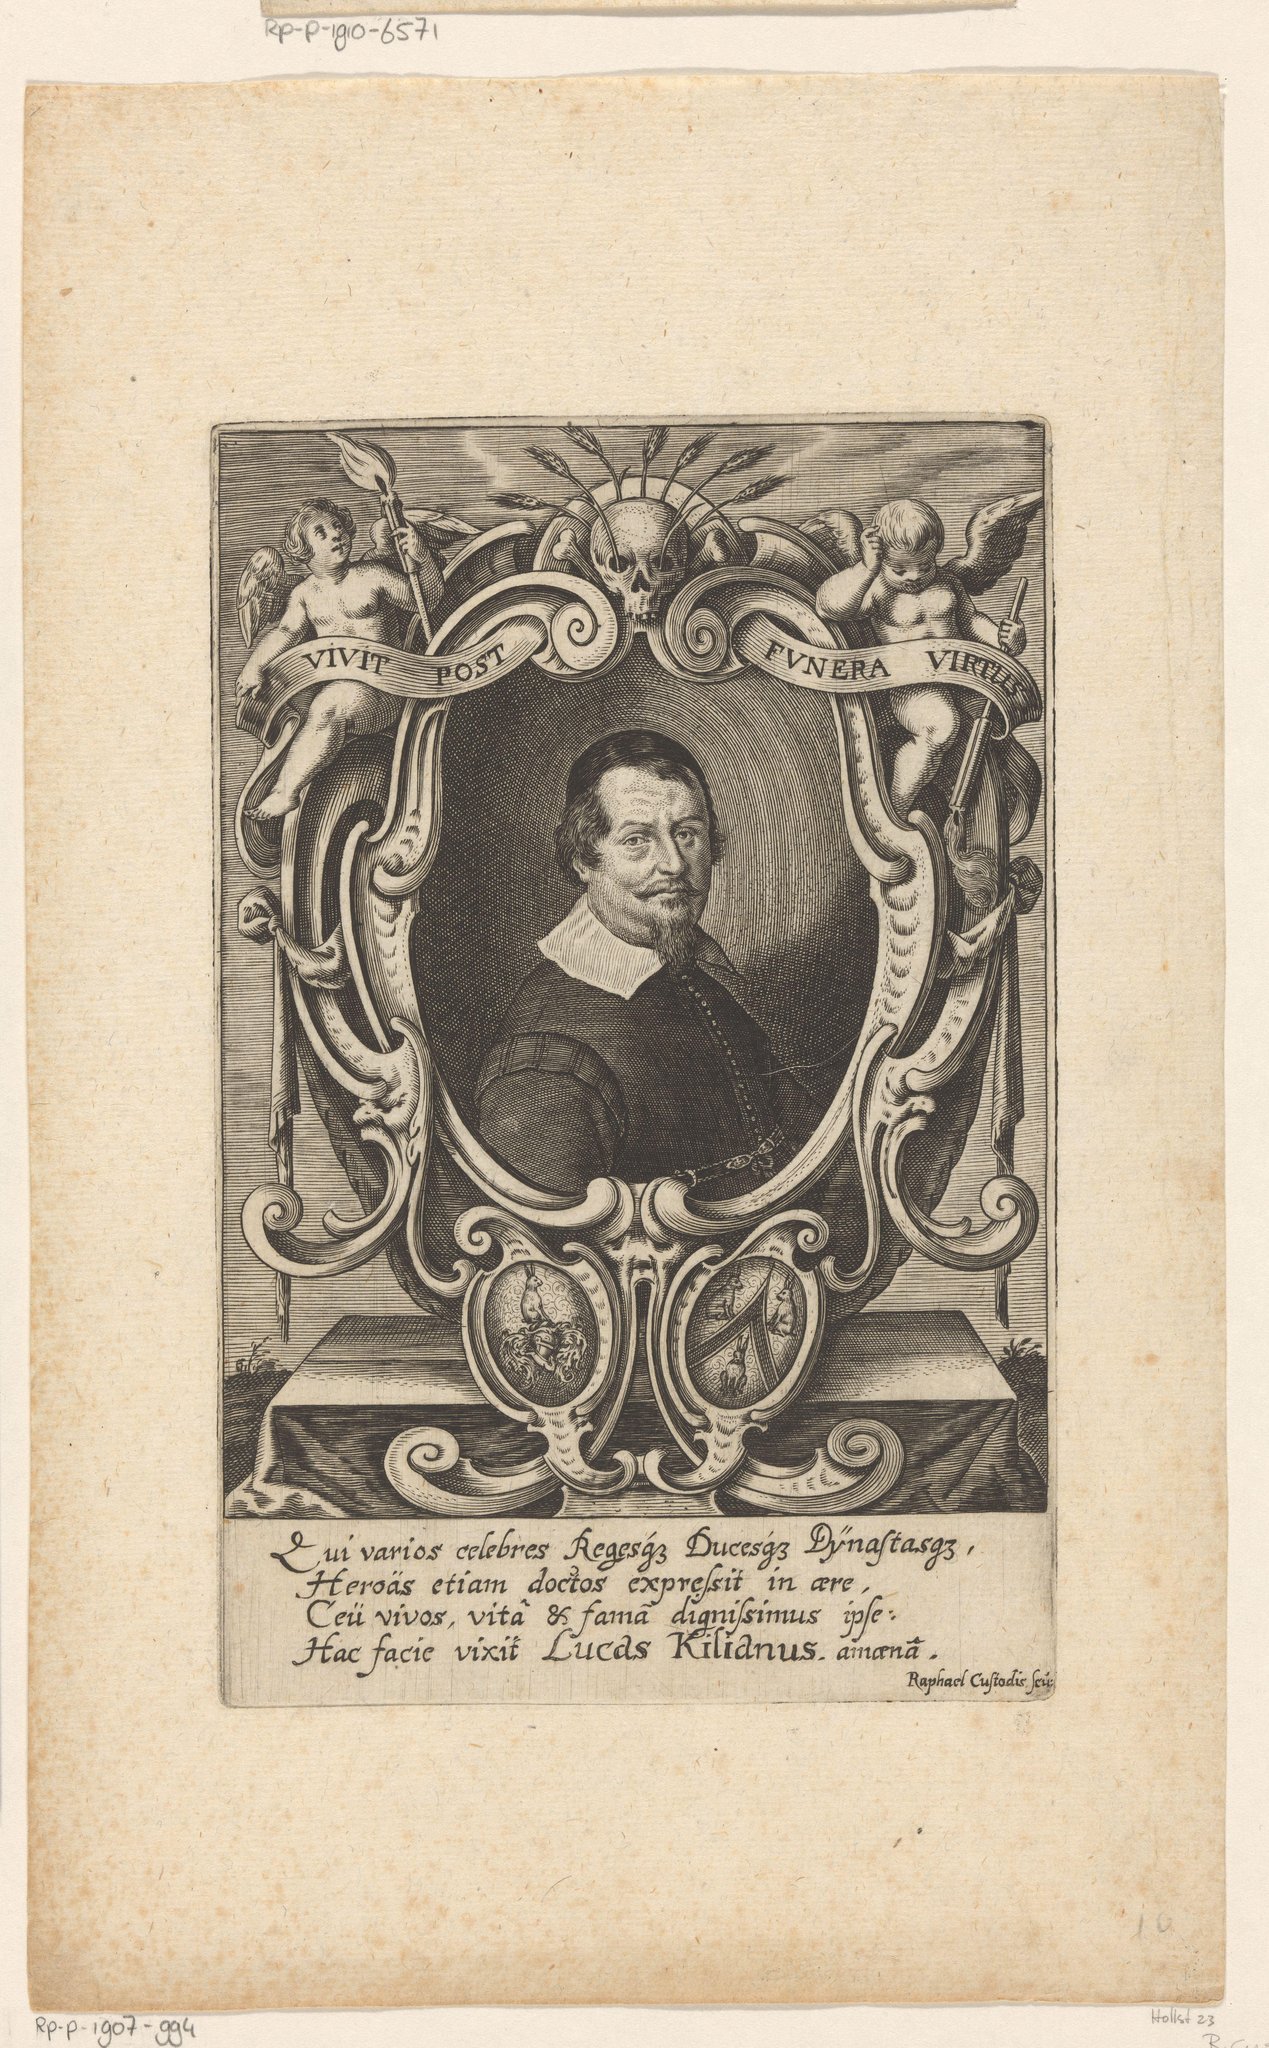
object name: print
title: Portret van Lucas Kilian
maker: raphael custos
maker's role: print maker, publisher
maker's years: 1590-1664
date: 1637-1664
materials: paper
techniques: engraving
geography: augsburg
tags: augsburg, print maker, draughtsman, torch - bb - torch held upside down, portrait, self-portrait of artist, cupids: 'amores', 'amoretti', 'putti', armorial bearing, heraldry, death's head, skull (symbol of death)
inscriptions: collector's mark: Lugt 2228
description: Portret in gedecoreerde cartouche met iconografische elementen die duiden op het overlijden van de geportretteerde.